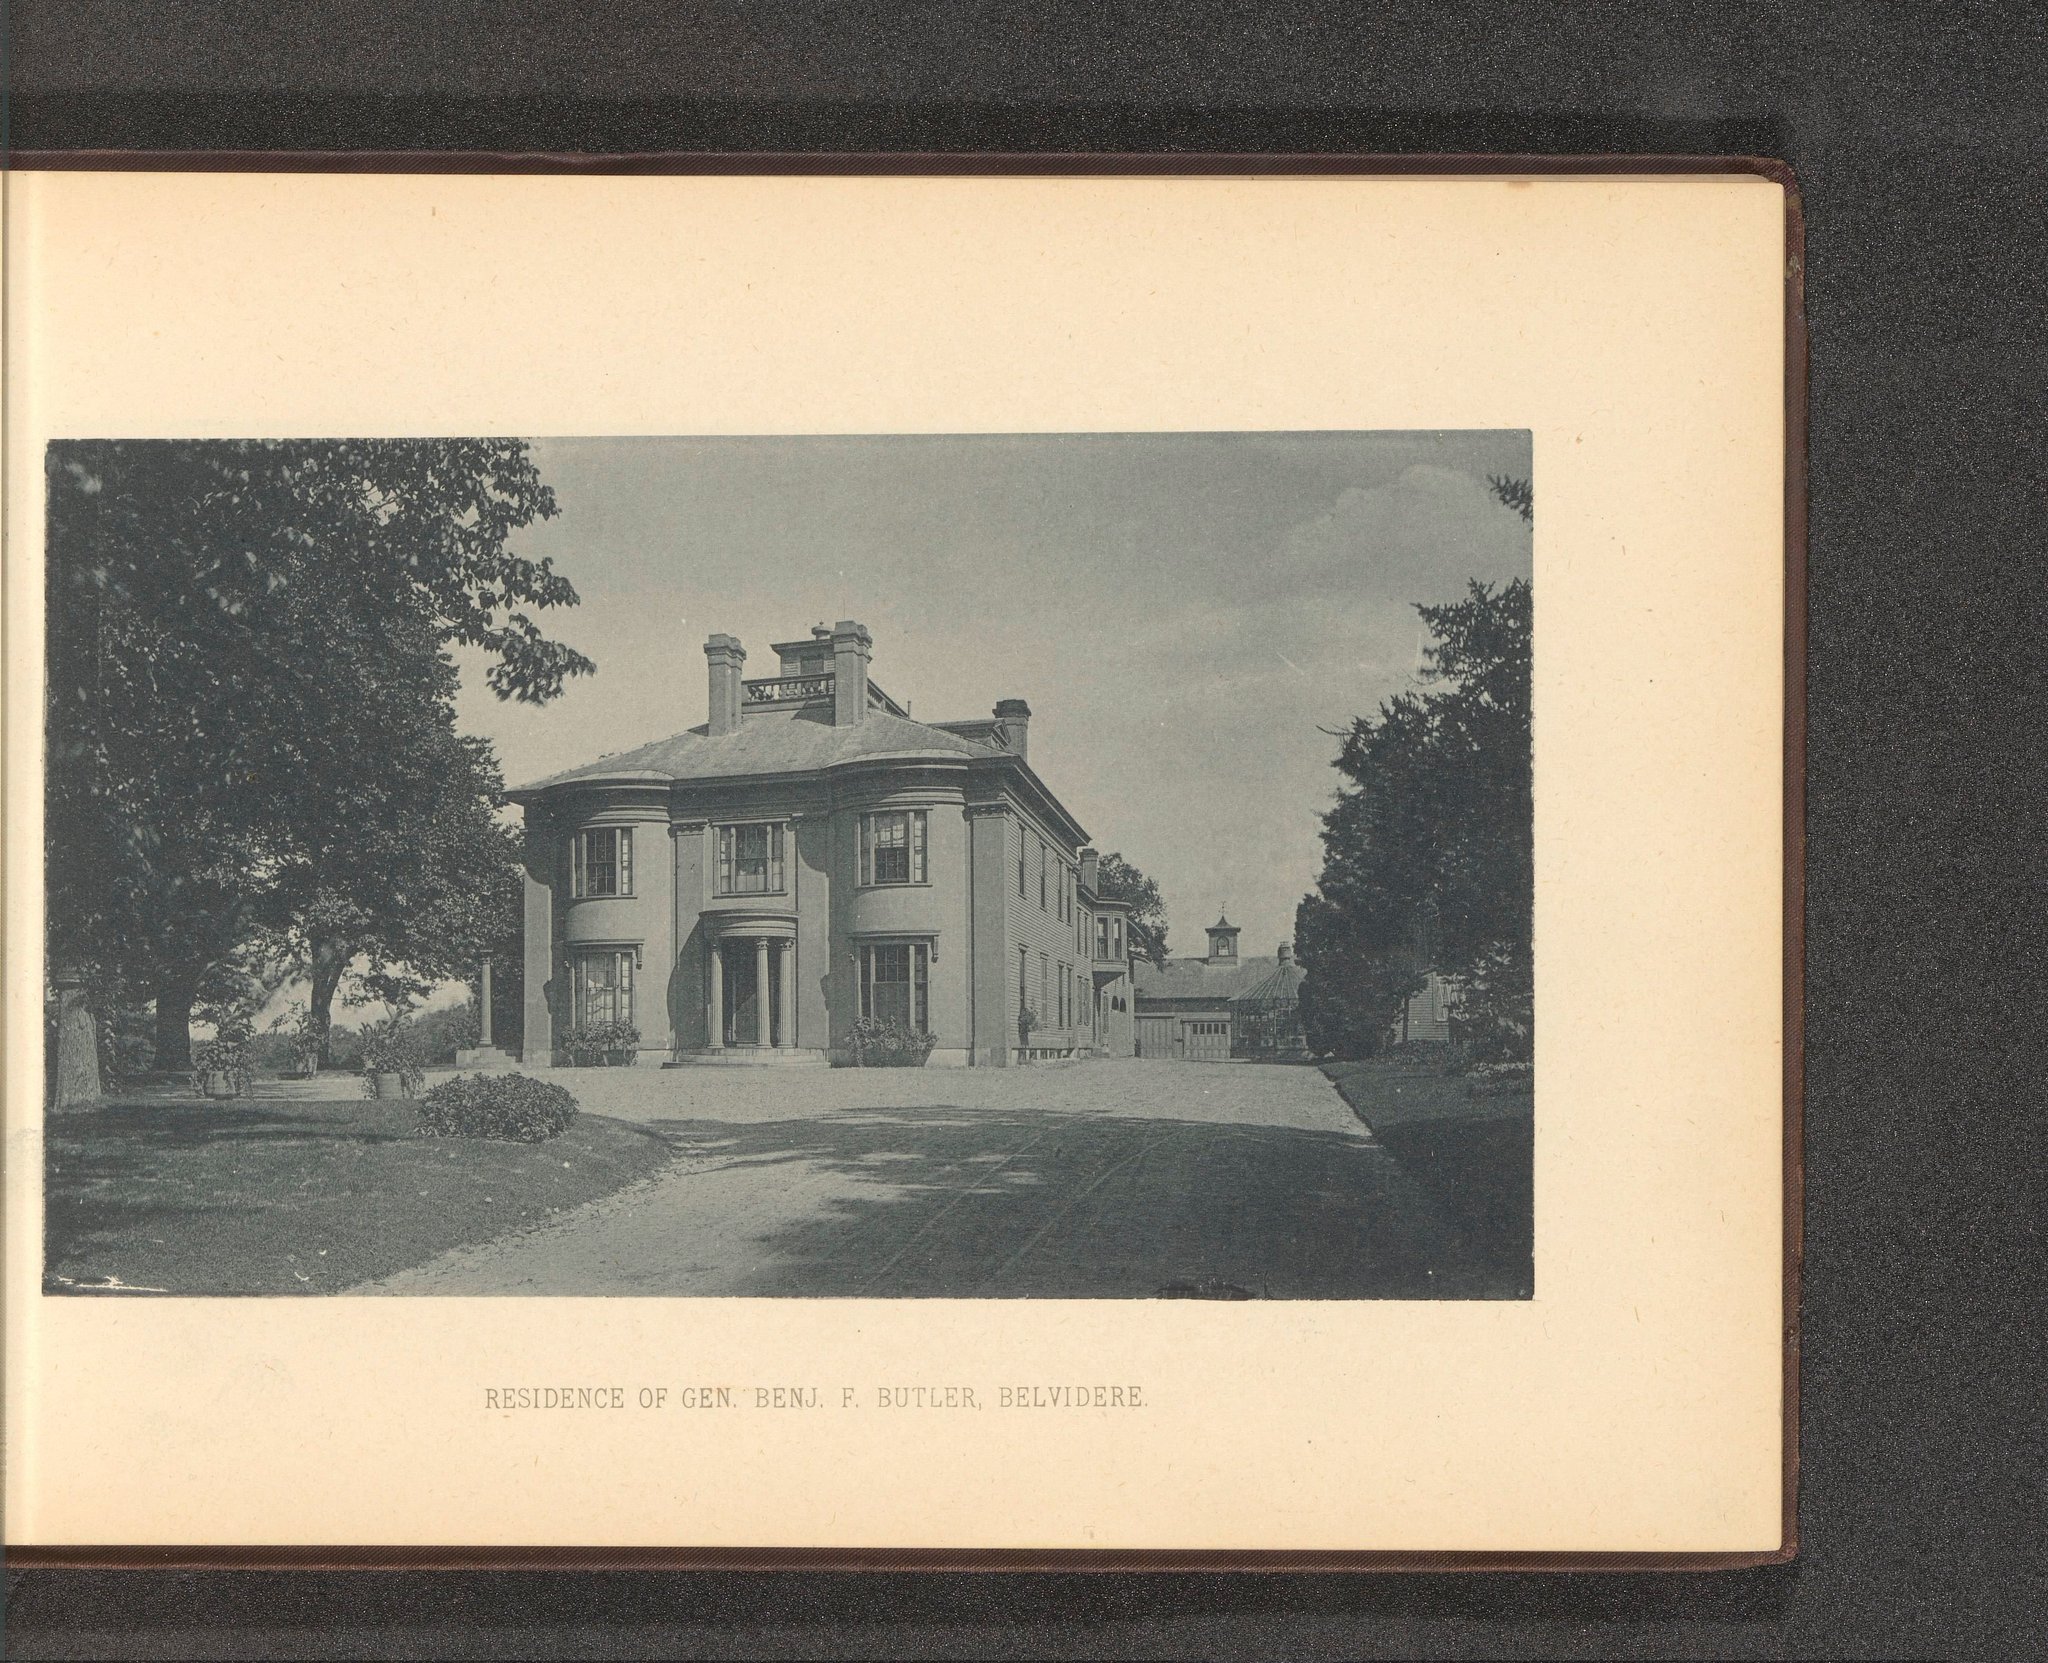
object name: page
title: Residence of gen. Benj. F. Butler, Belvidere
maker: Anonymous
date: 1887-1892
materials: paper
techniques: photograph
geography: belvidere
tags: villa, façade (of house or building)